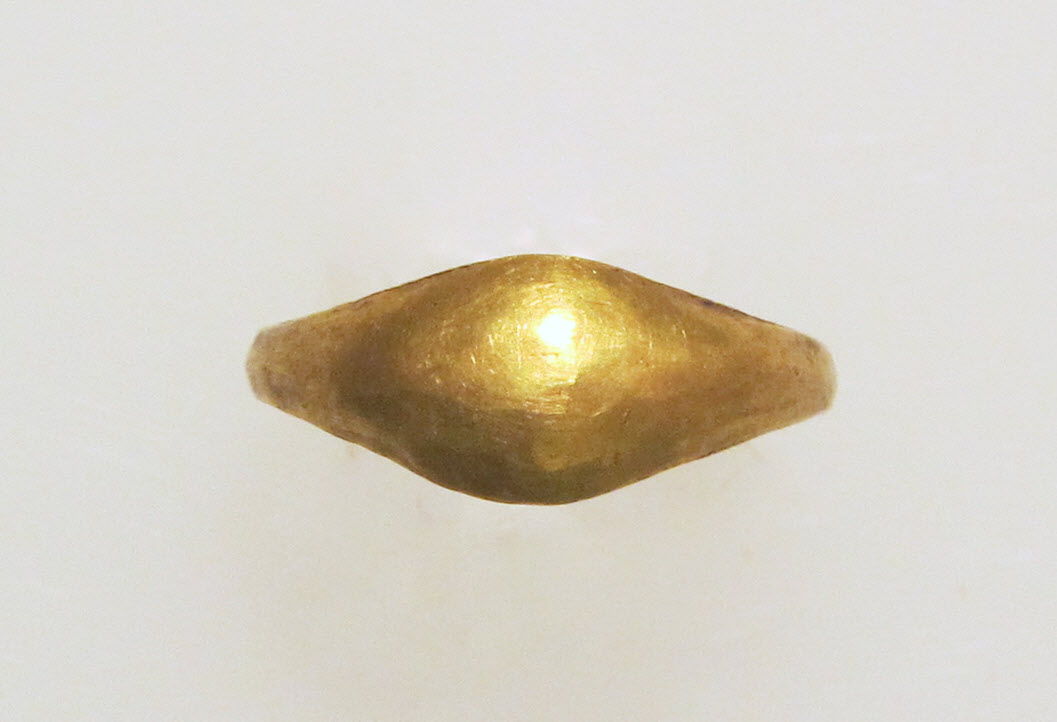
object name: ring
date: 7000 BCE-330 CE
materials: gold